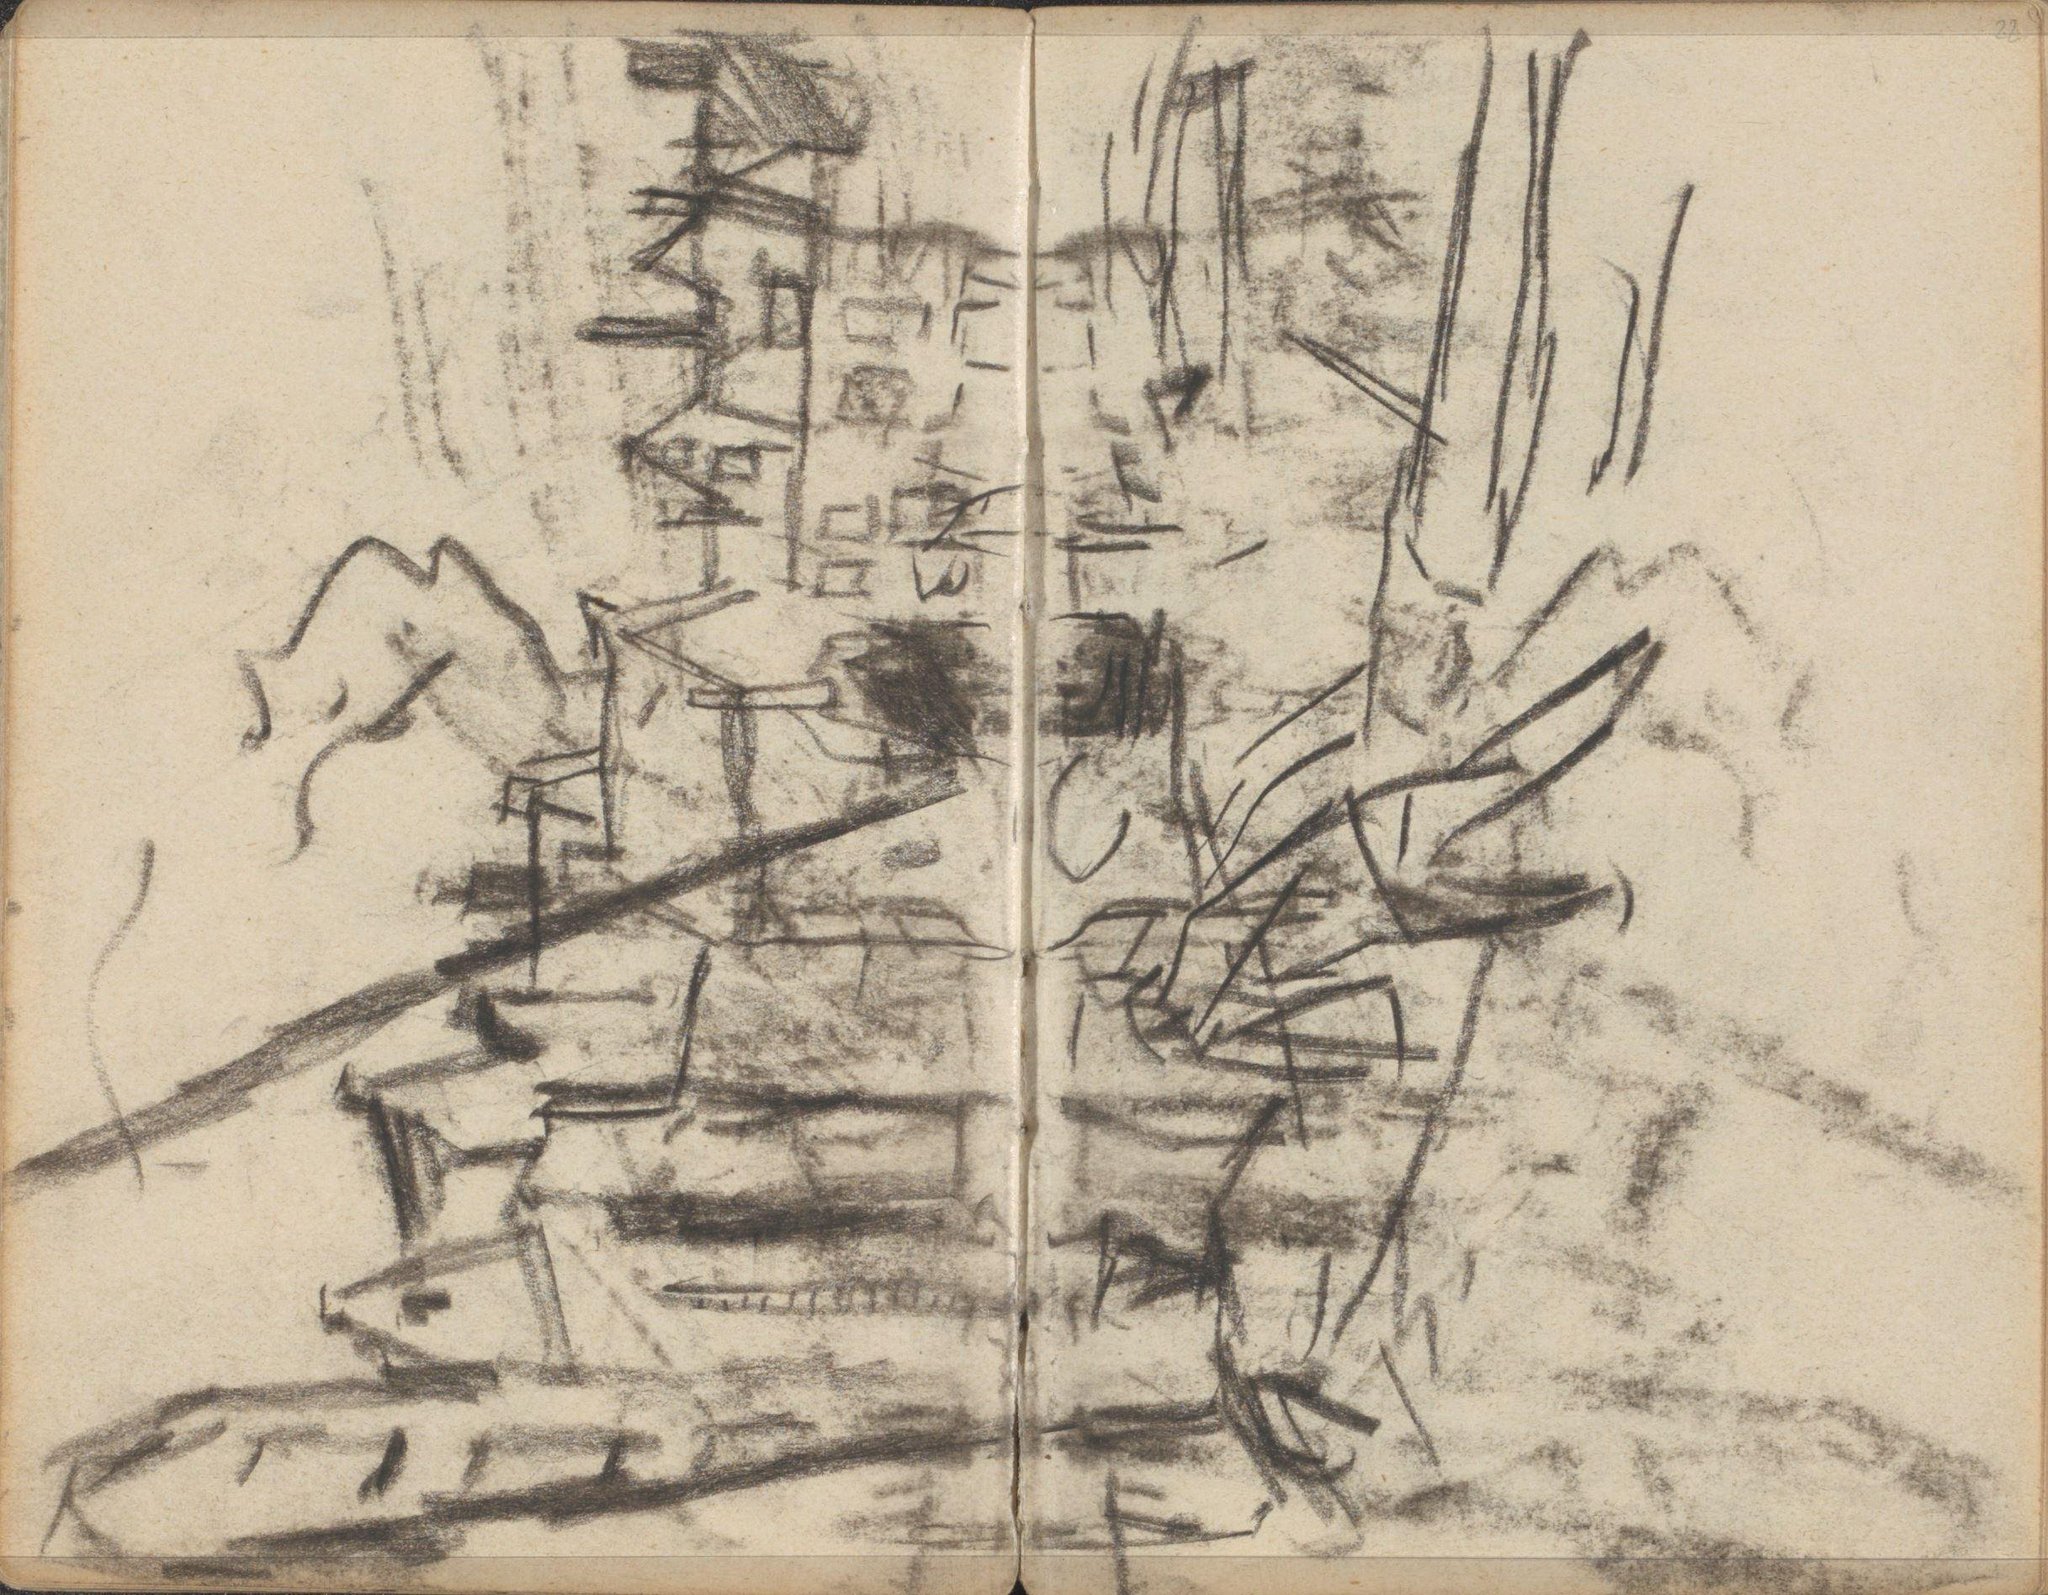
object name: sketchbook leaf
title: Gezicht in Amsterdam met arbeiders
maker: george hendrik breitner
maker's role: draughtsman, painter, print maker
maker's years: 1857-1923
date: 1910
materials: chalk, paper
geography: amsterdam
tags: demolition of building, building-site, civic architecture; edifices; dwellings, amsterdam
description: Waarschijnlijk sloopwerkzaamheden. Pagina 21 en pagina 22 uit een schetsboek met 45 bladen.